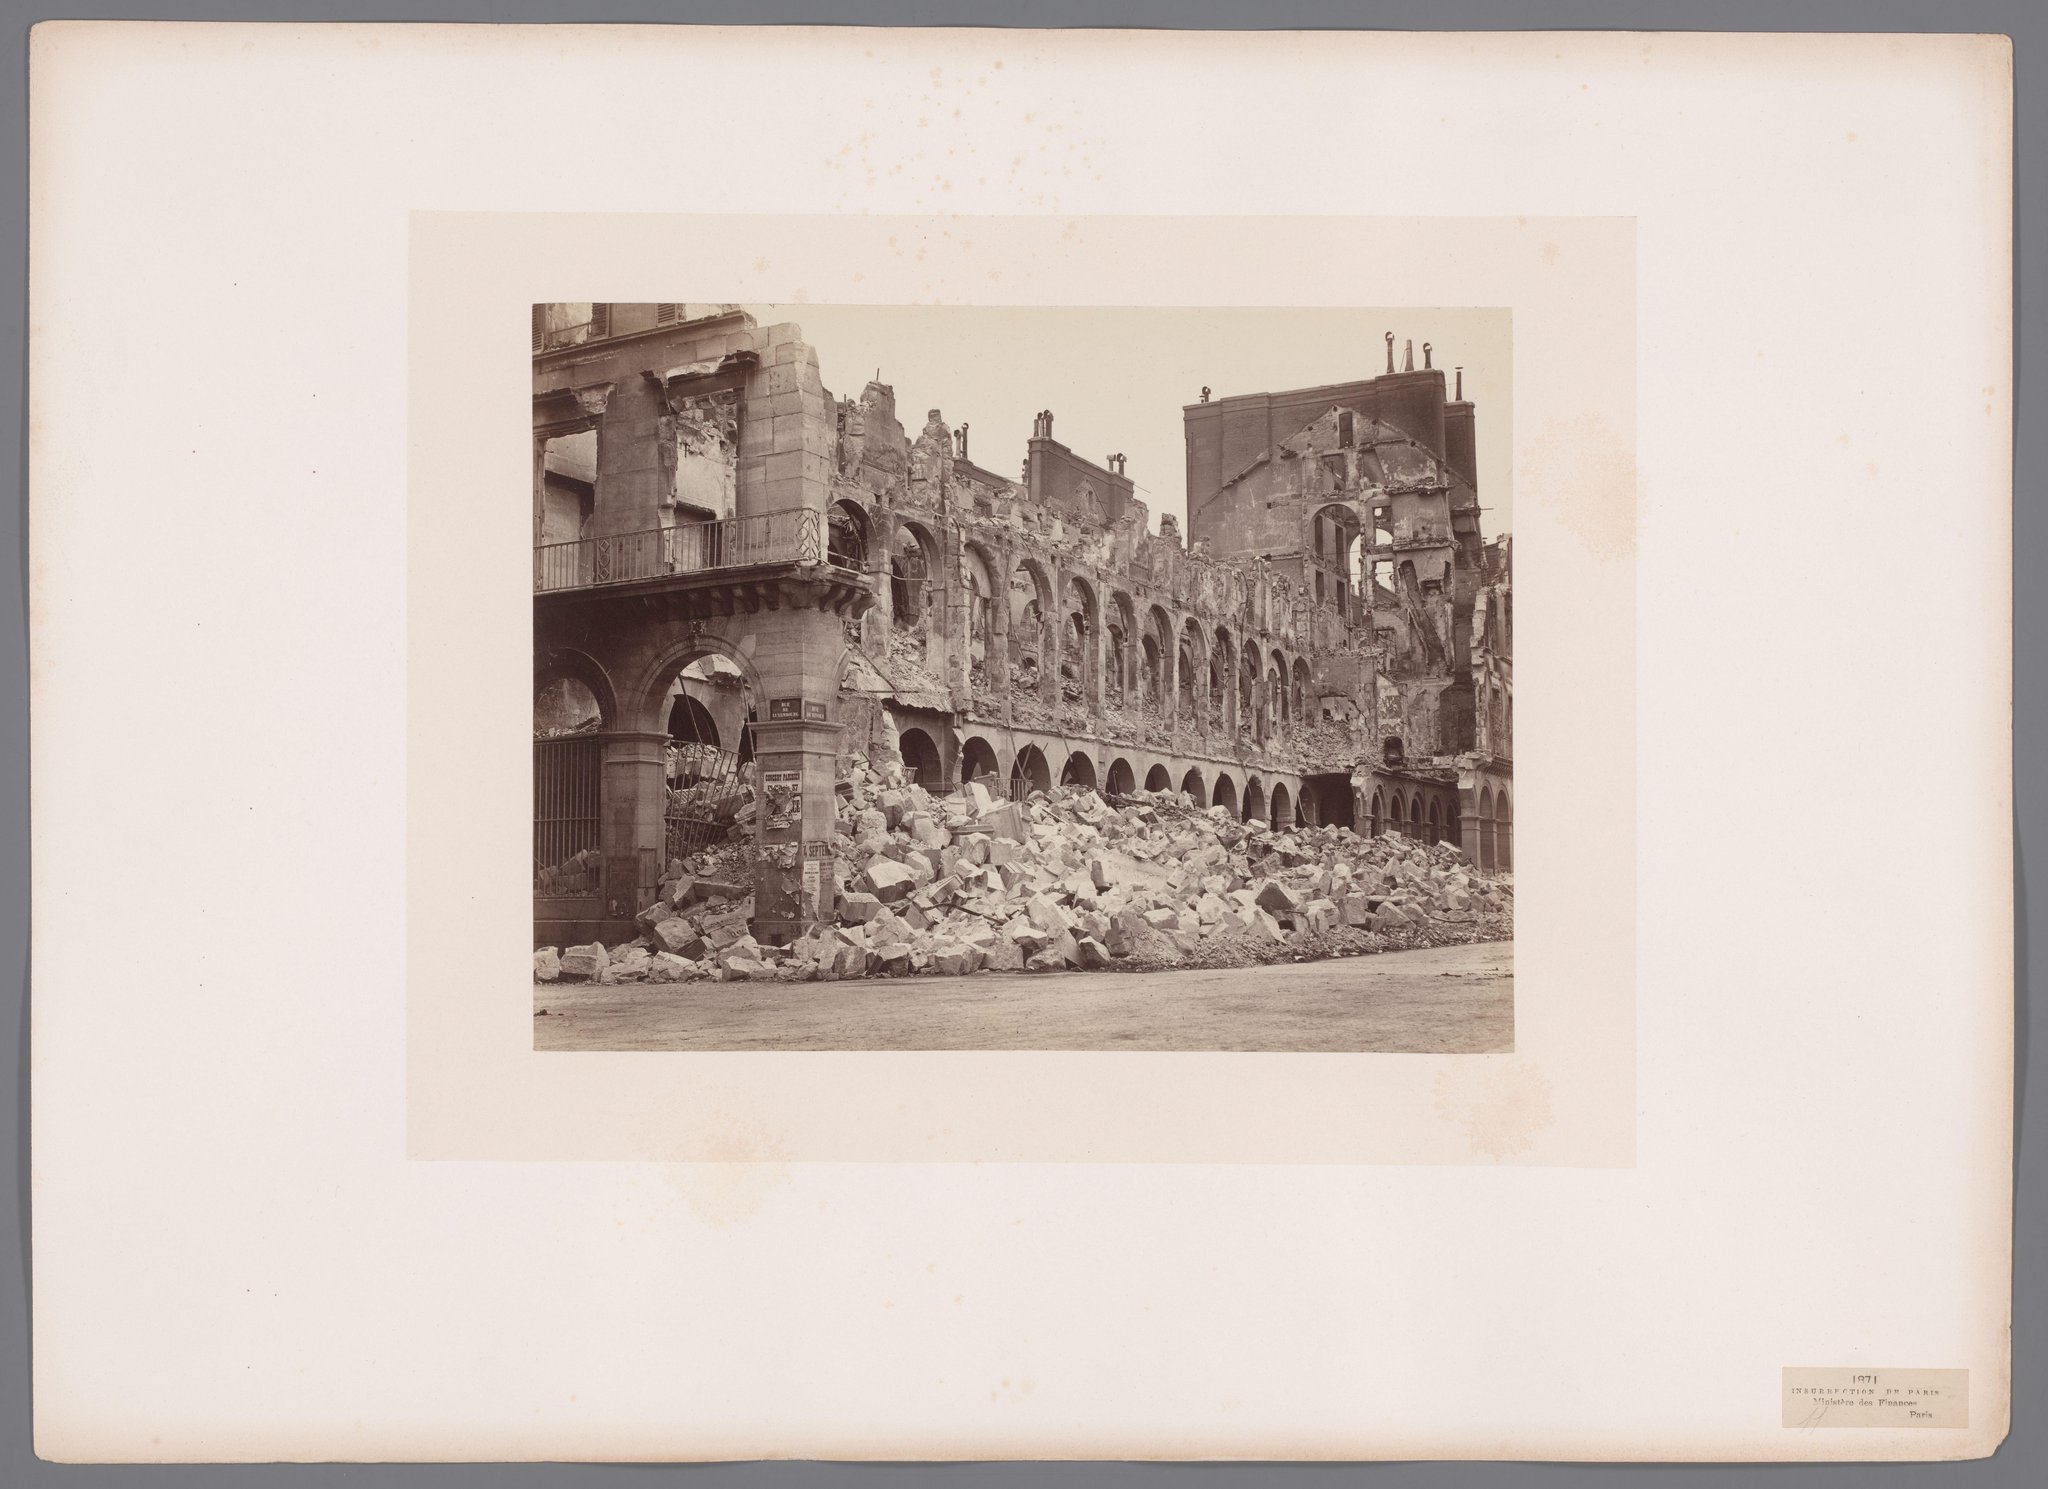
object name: photograph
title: The Destroyed Ministry of Finance on Rue Rivoli and Ruined Buildings on Place de la Bastille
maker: Anonymous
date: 1871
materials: paper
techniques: albumen print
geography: france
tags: devastated, ruined place or city (~ warfare)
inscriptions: label: ‘(gedrukt) 1871 / INSURRECTION DE PARIS / Ministère des Finances / Paris; (potlood) 11’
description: After the Franco-Prussian War in 1871, Paris was reduced to rubble and still occupied by Prussian soldiers. The population contended with famine and misery. Everything had come to a standstill and poverty was widespread. The ‘peace’ of the new French government and the imposed taxes felt like a betrayal. The Communards revolted against their own government and torched the town hall, palaces, and government buildings.